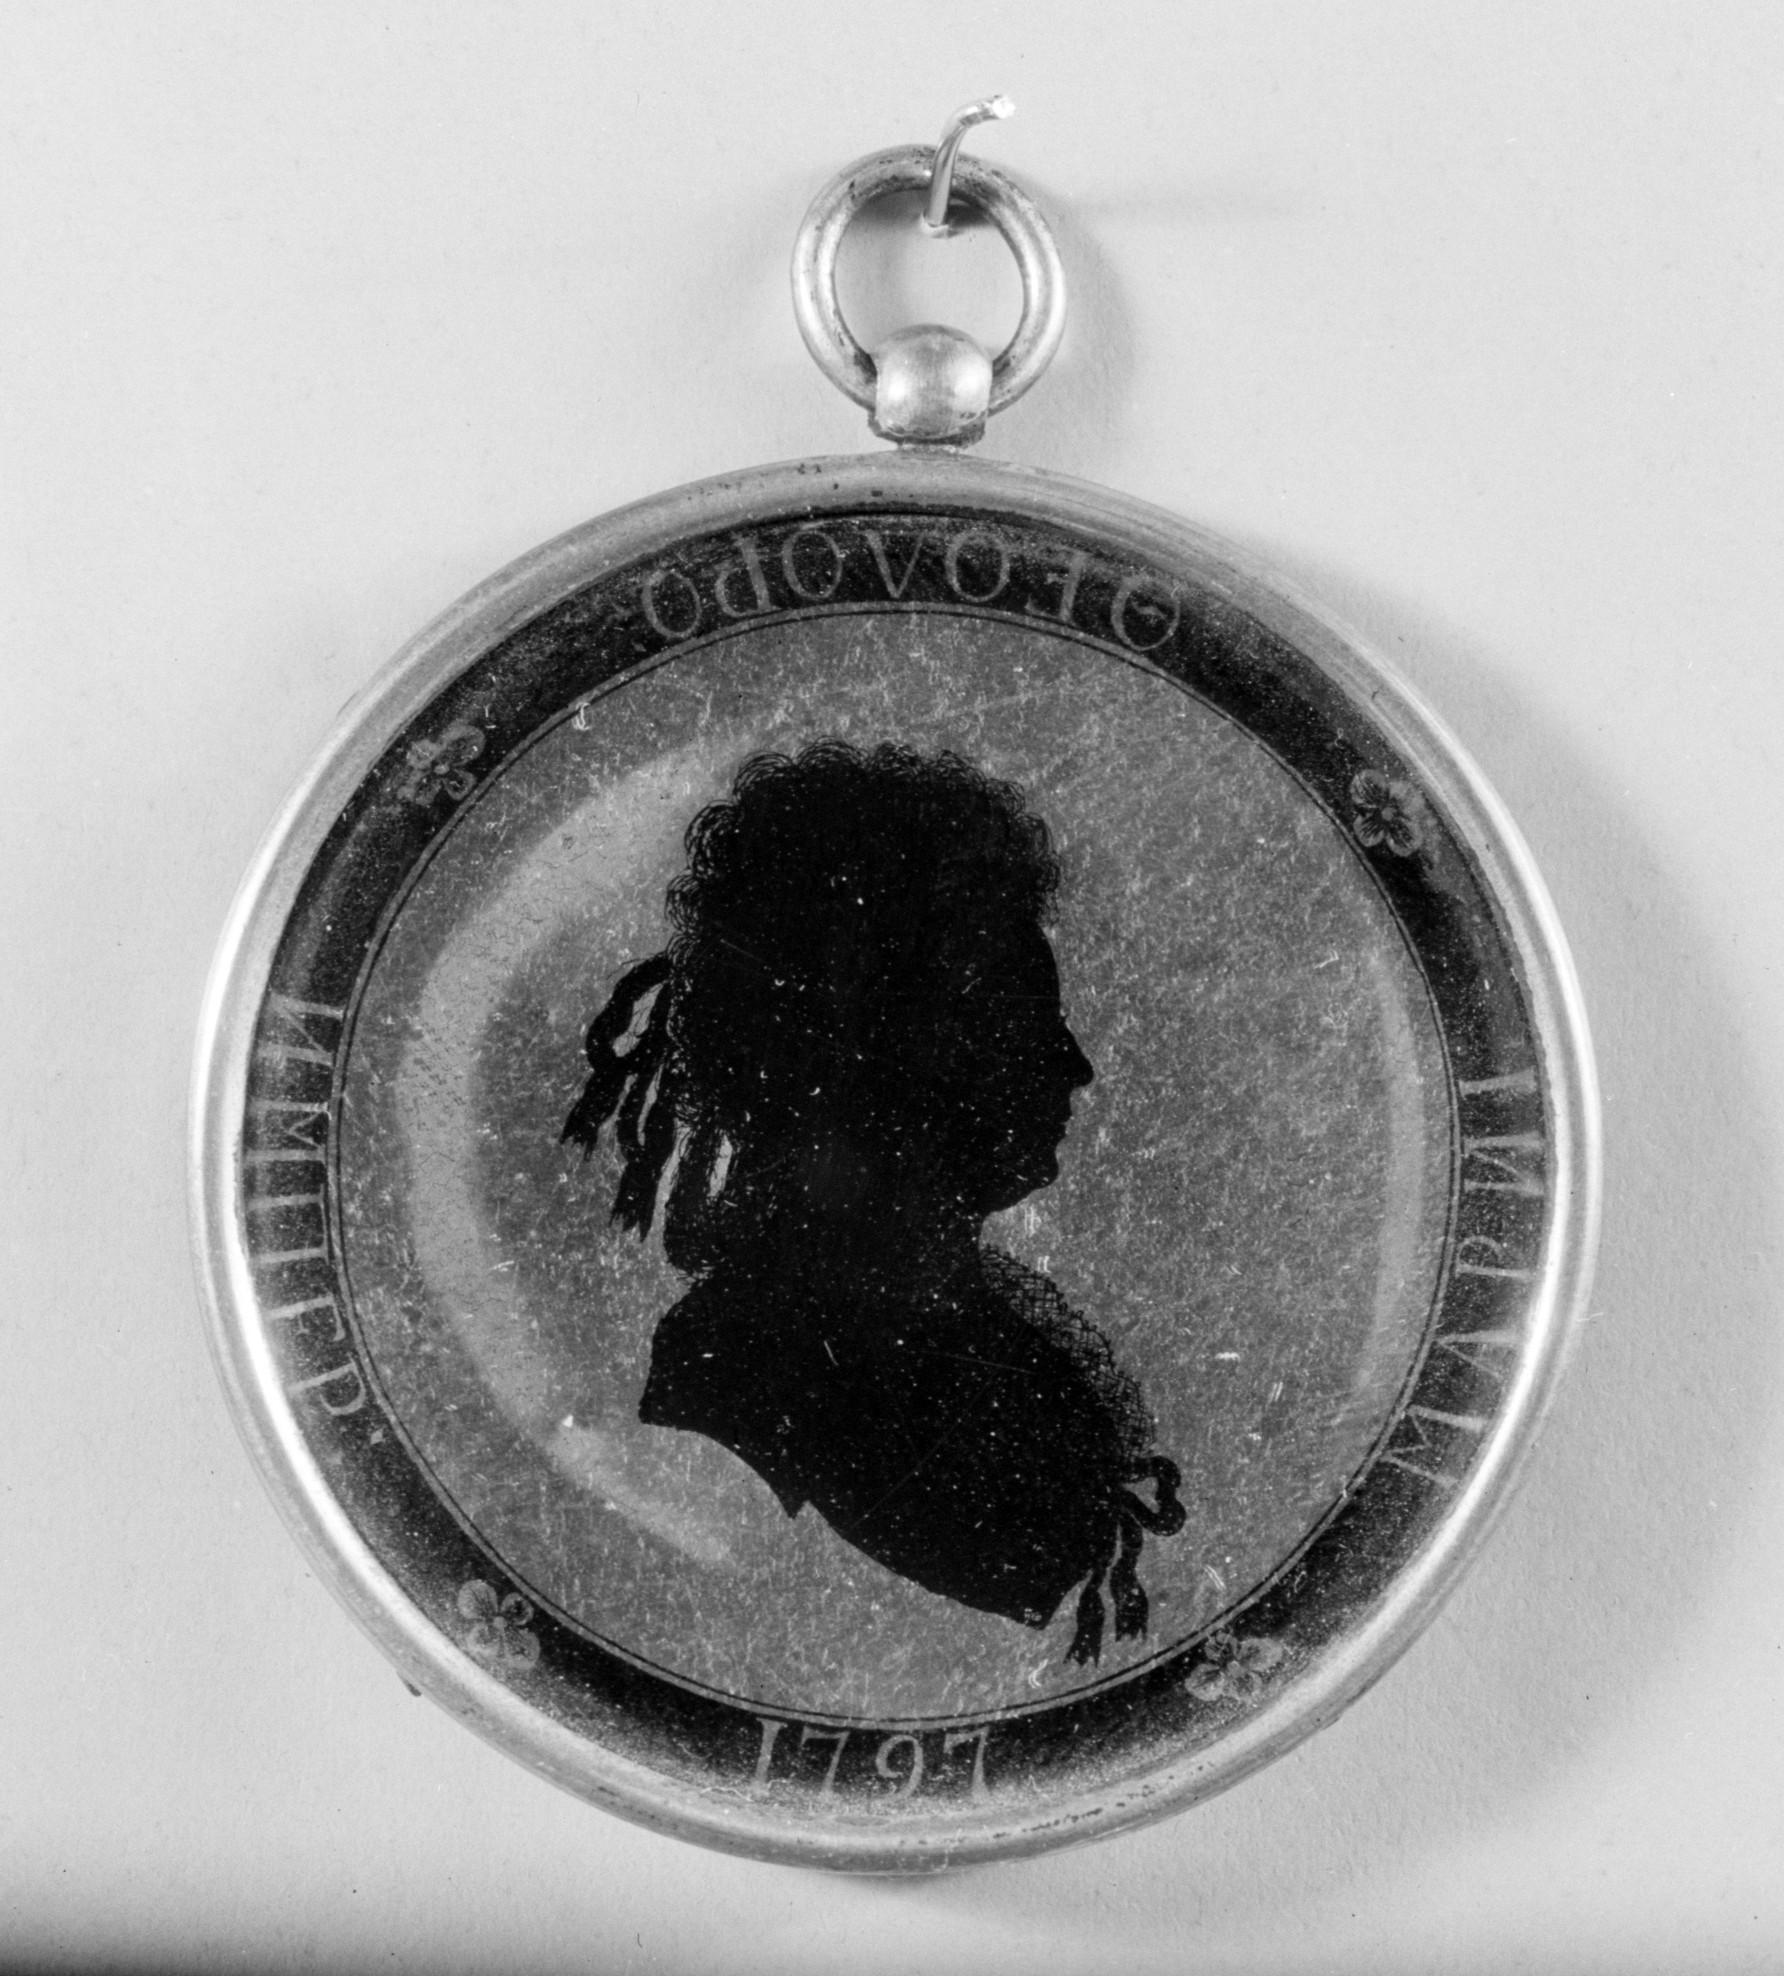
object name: pendant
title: Silhouette of Empress Maria Feodorovna of Russia (1759–1828)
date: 1797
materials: silver gilt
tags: profiles,women